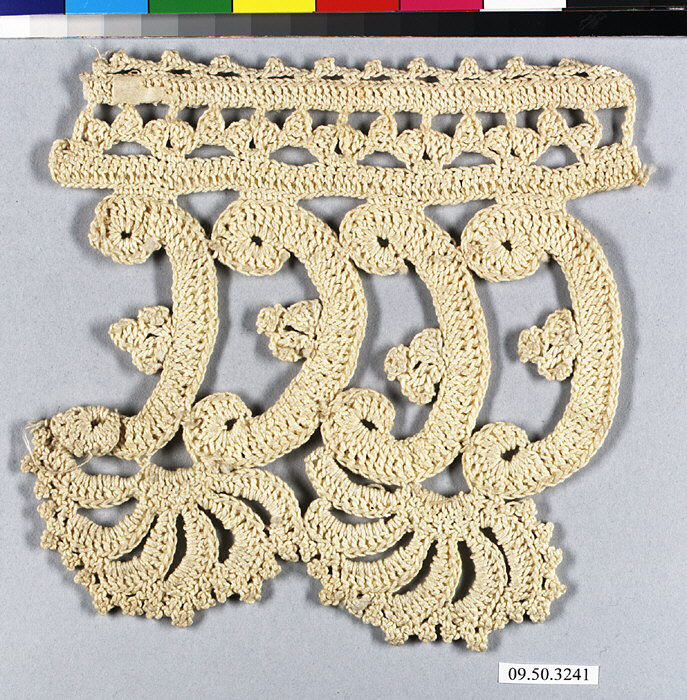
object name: sample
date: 1801-1900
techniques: crochet